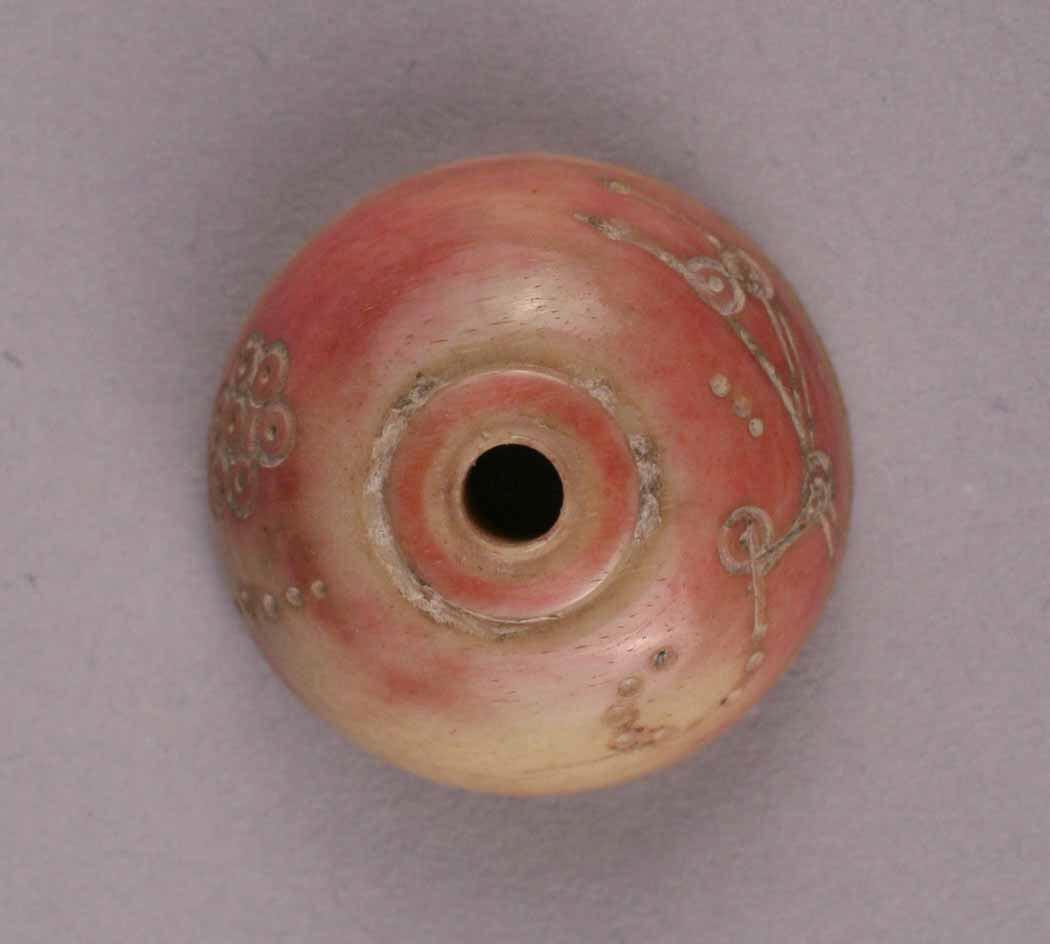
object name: spindle whorl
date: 801-1000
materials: bone, paint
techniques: incising, inlay, tinting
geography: iran